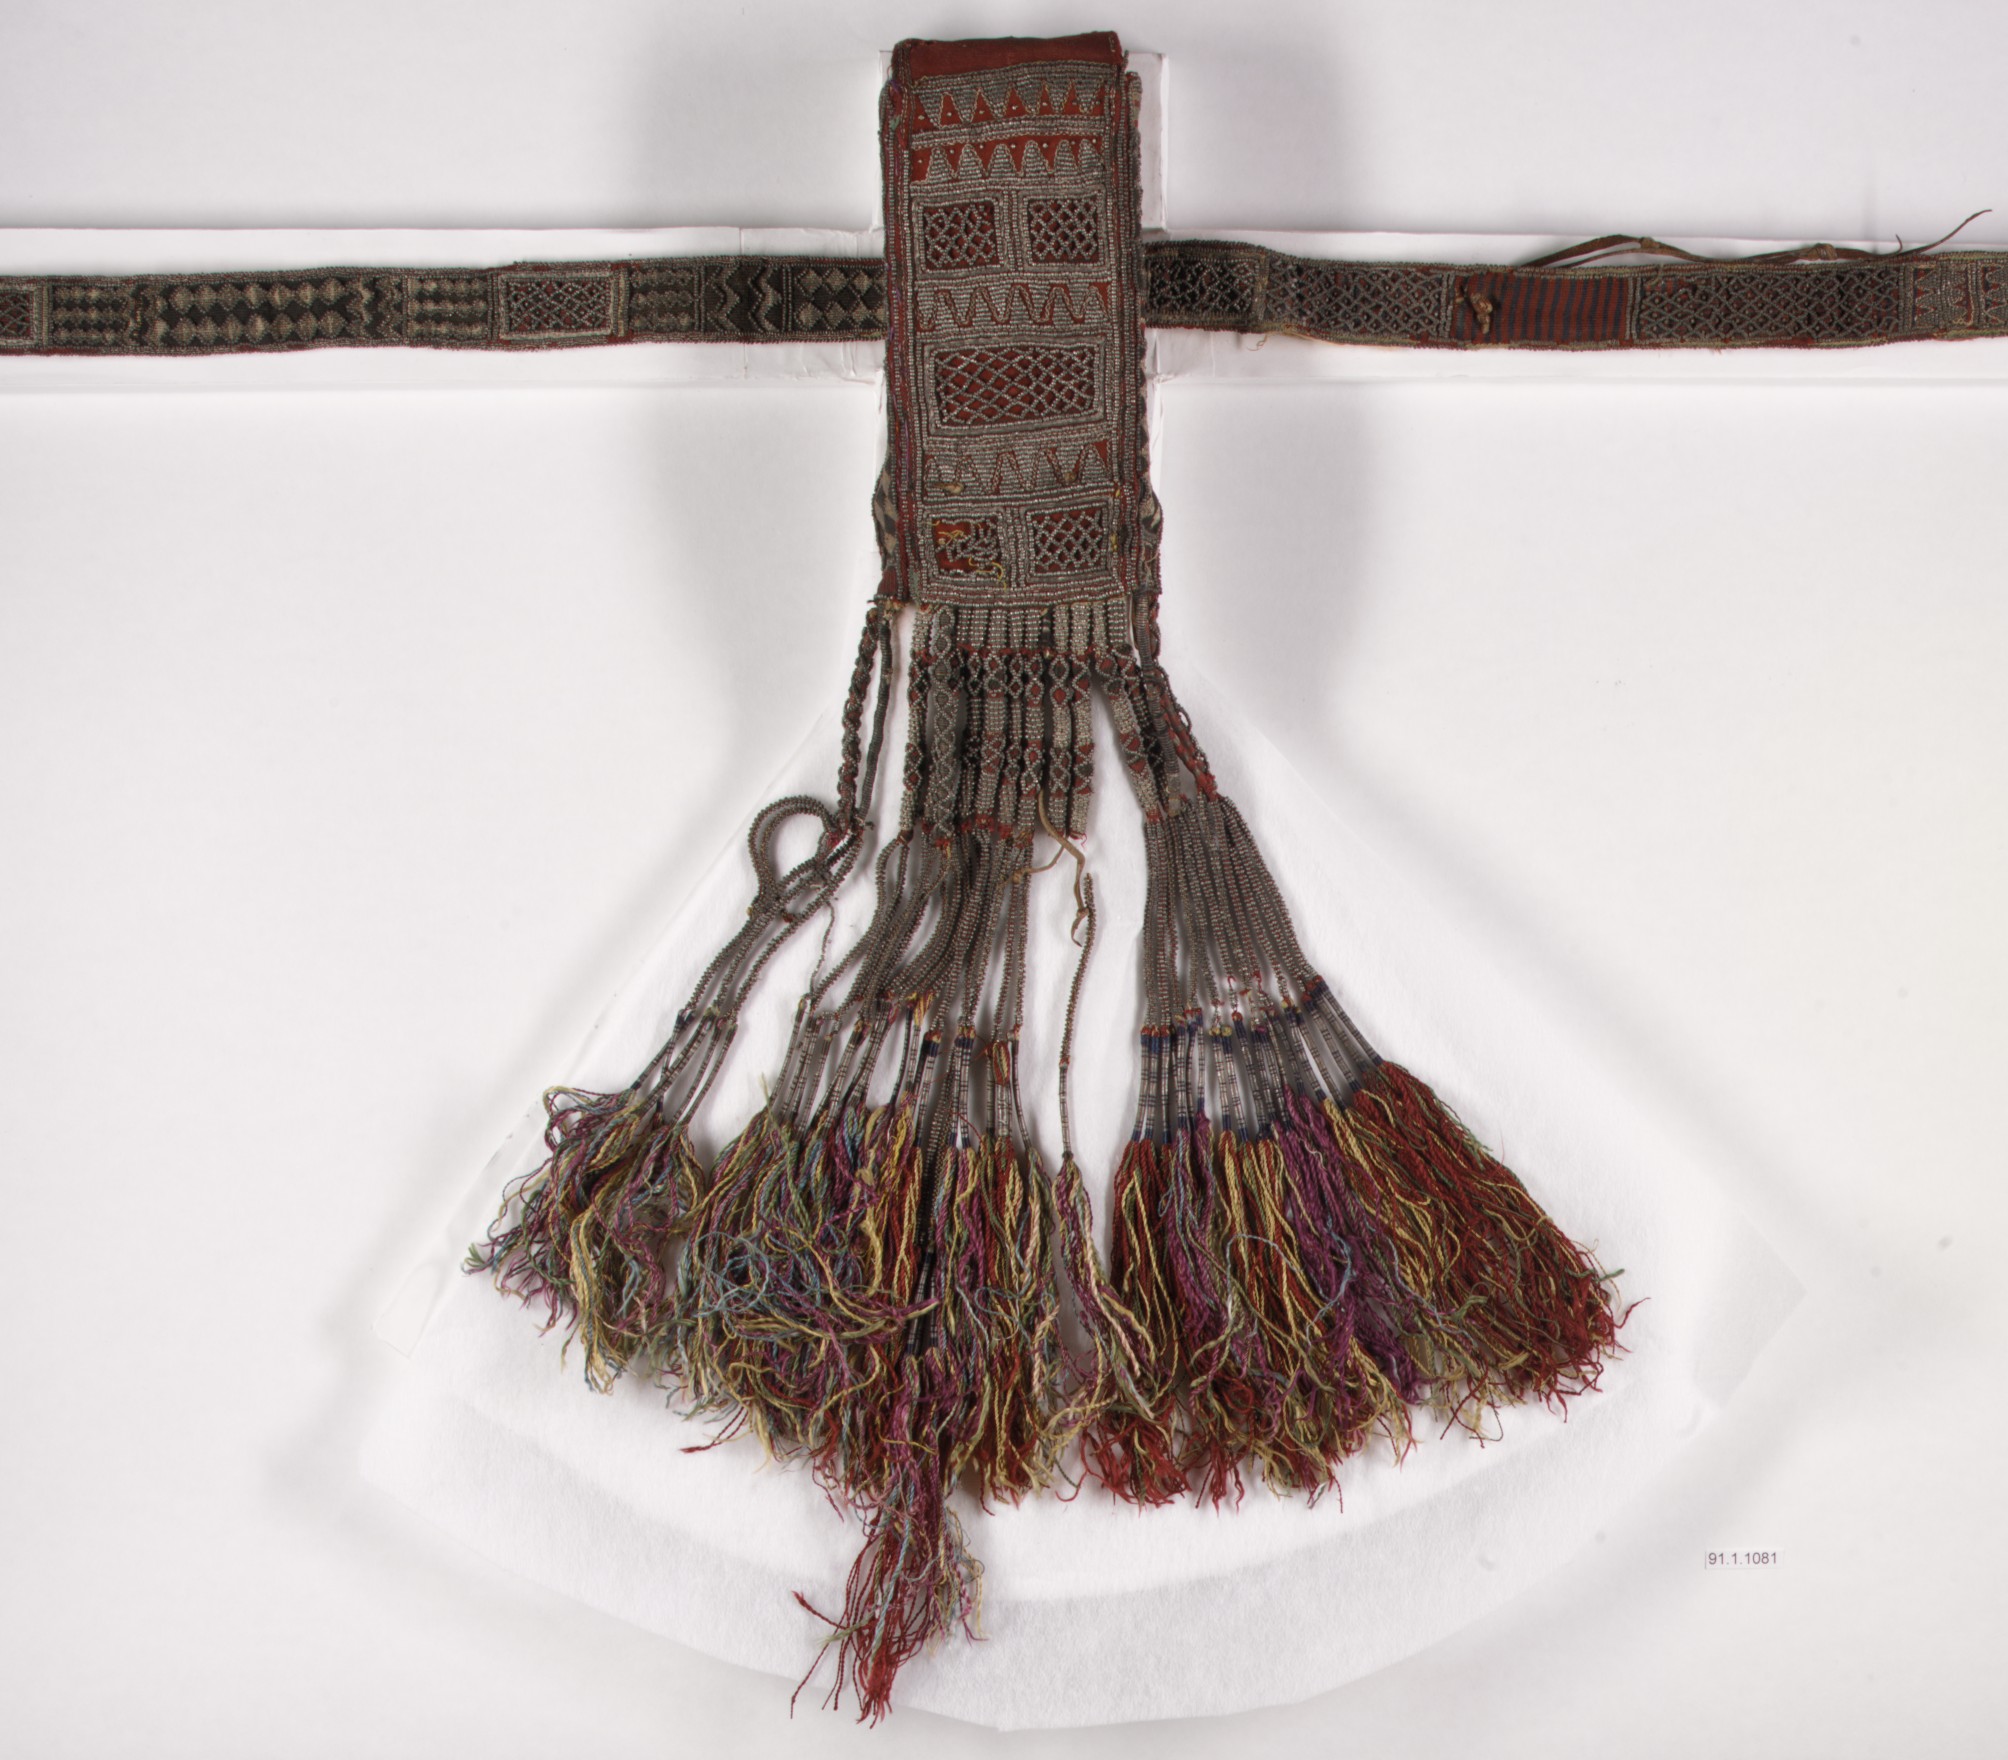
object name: belt pouch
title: Belt and Pouch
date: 1701-1900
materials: metal thread, silk, wool